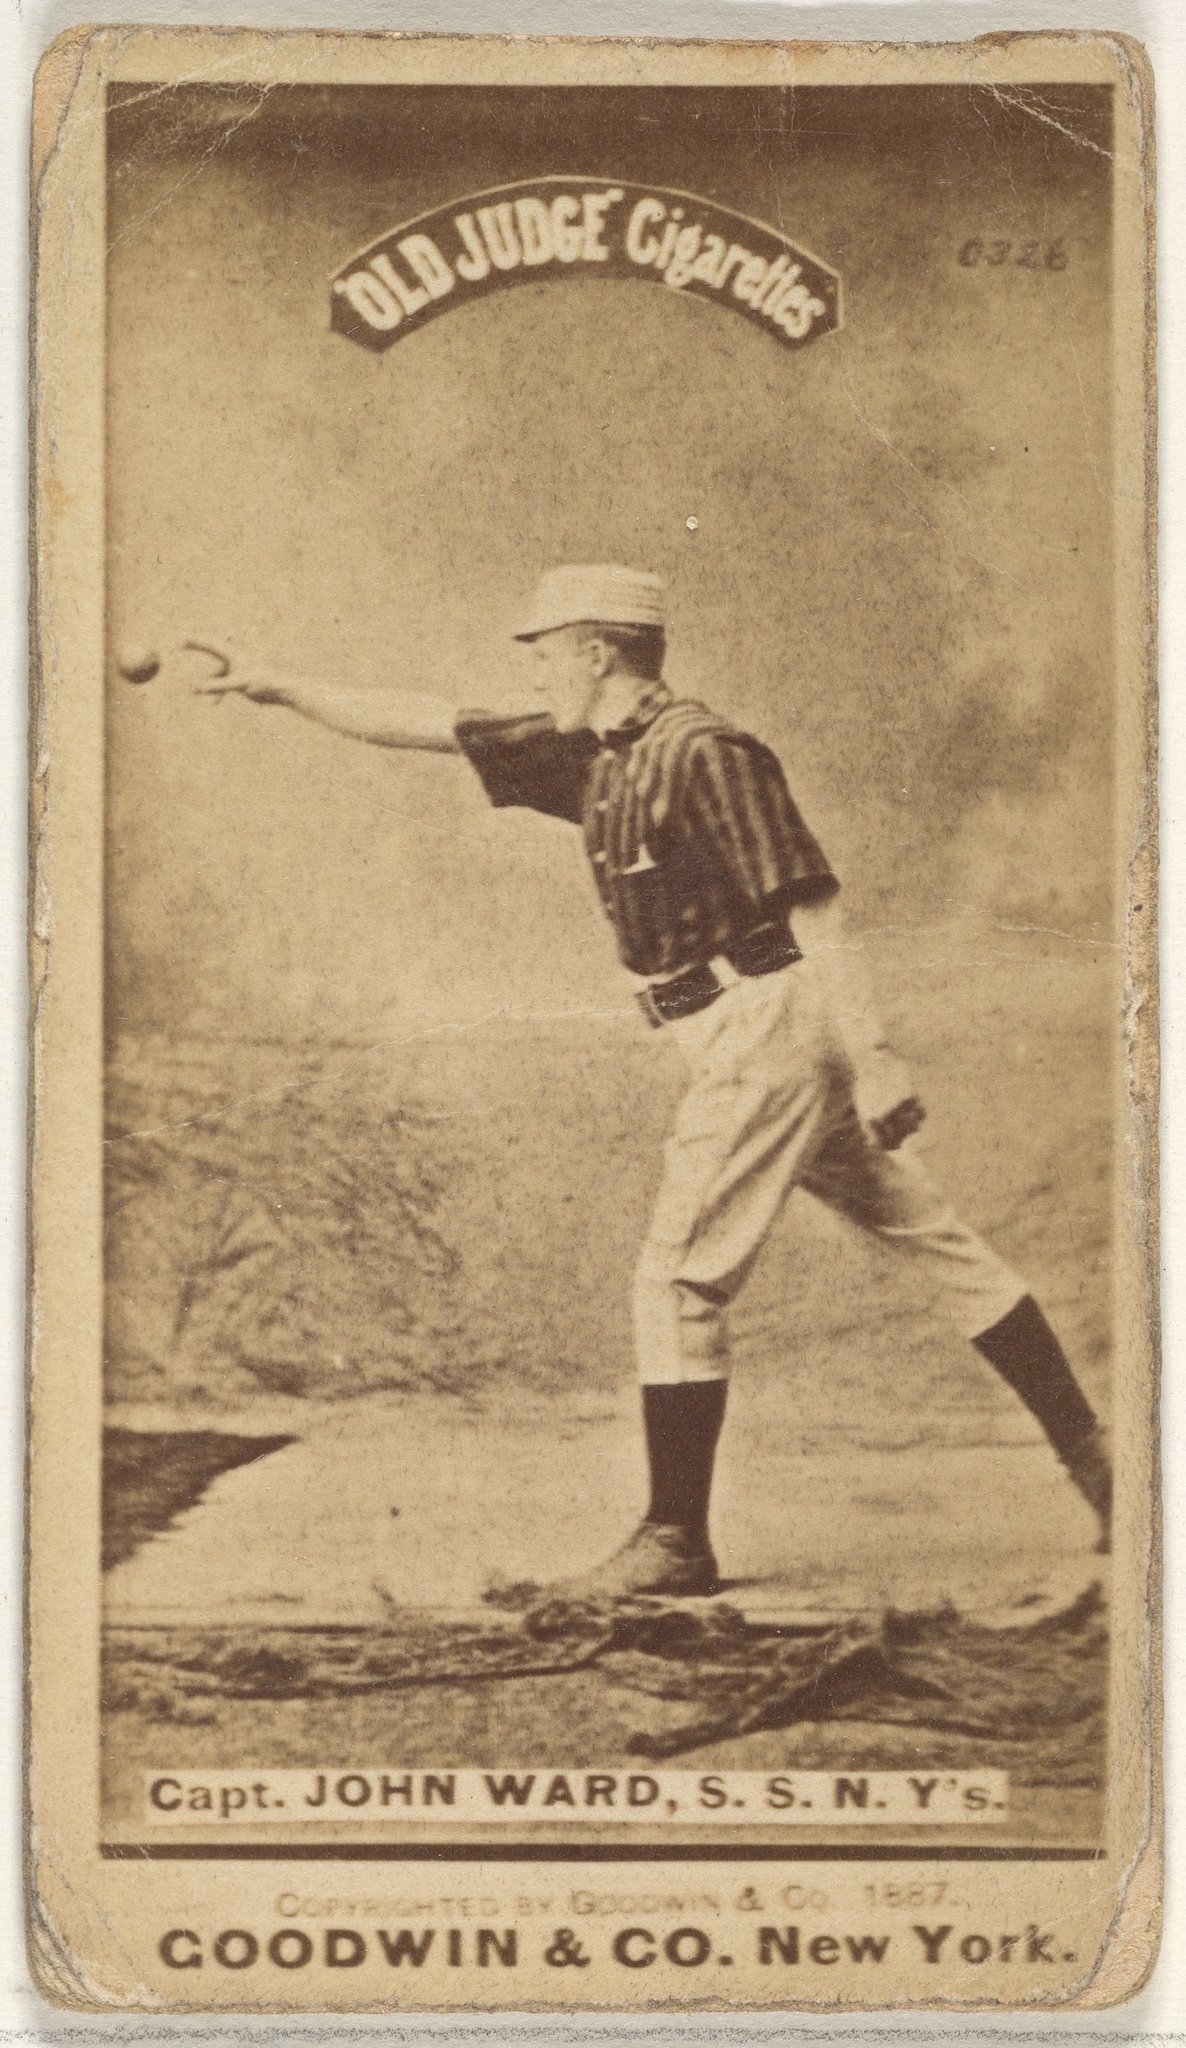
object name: baseball card, photograph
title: John Montgomery Ward, Captain and Shortstop, New York, from the Old Judge series (N172) for Old Judge Cigarettes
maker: goodwin & company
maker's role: publisher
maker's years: 1850-1950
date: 1887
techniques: albumen silver print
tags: men,portraits,baseball,athletes